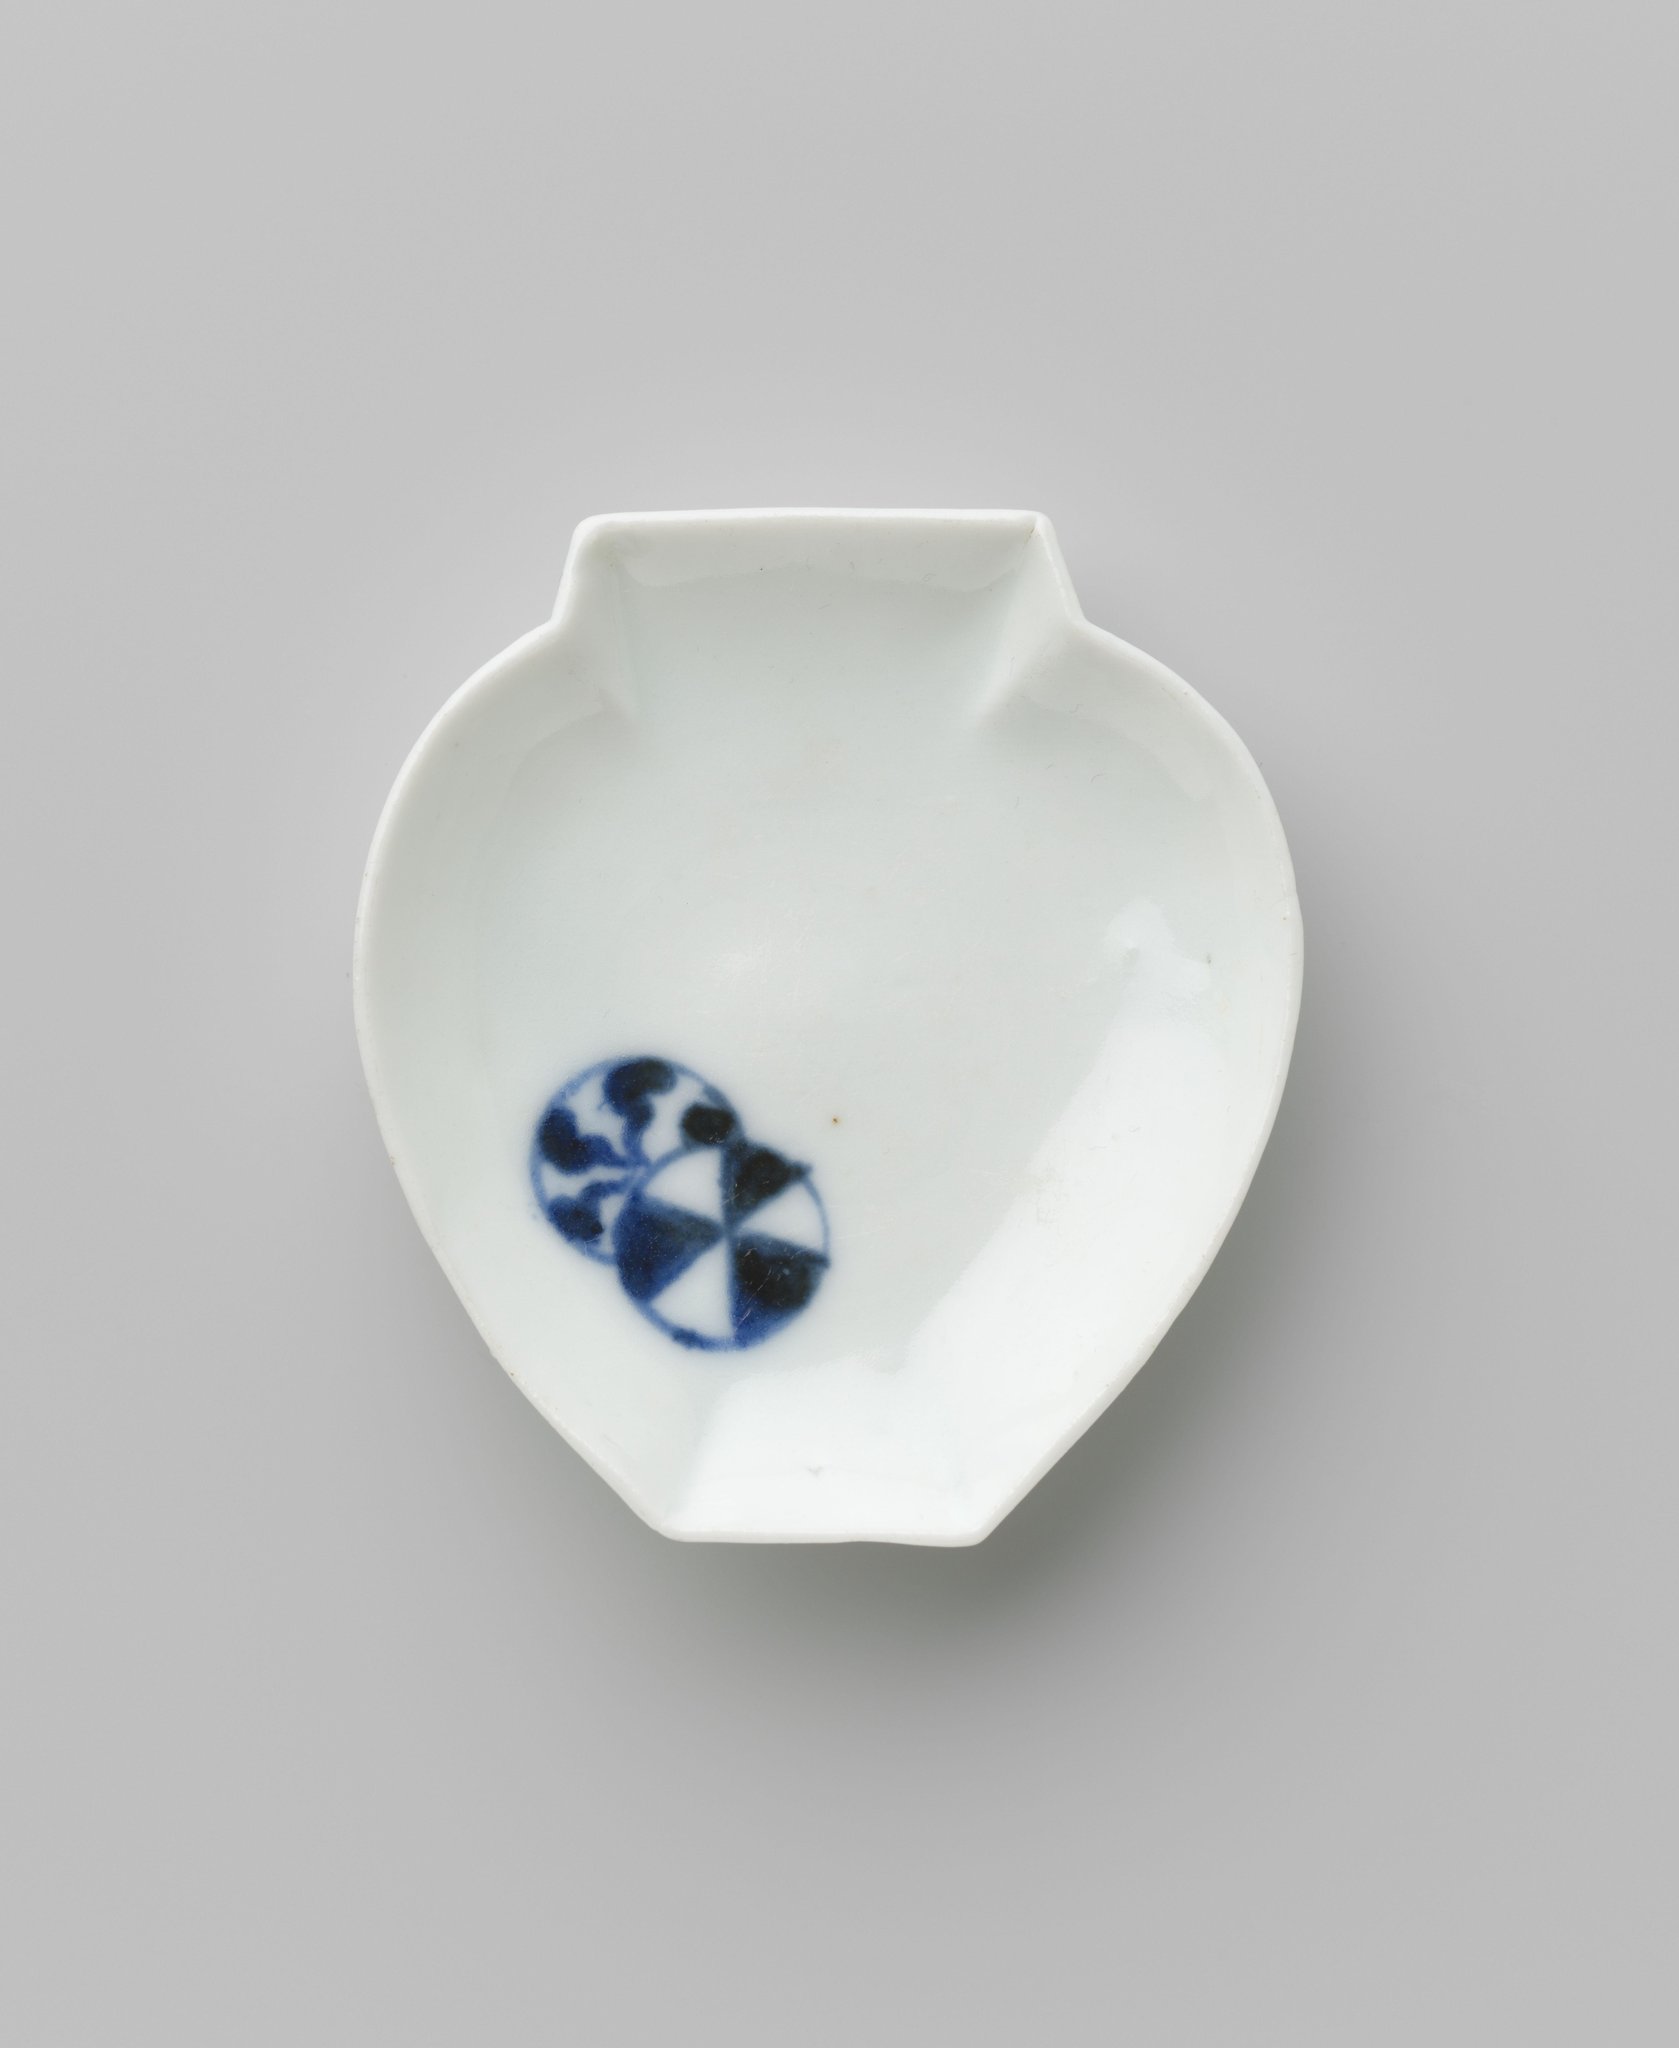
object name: miniature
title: Schotel van porselein in de vorm van een gesloten lotusbloem (?), blauwe onderglazuur decoratie van twee cirkels met Japanse man (bloemen)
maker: Anonymous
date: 1690-1710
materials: porcelain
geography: arita